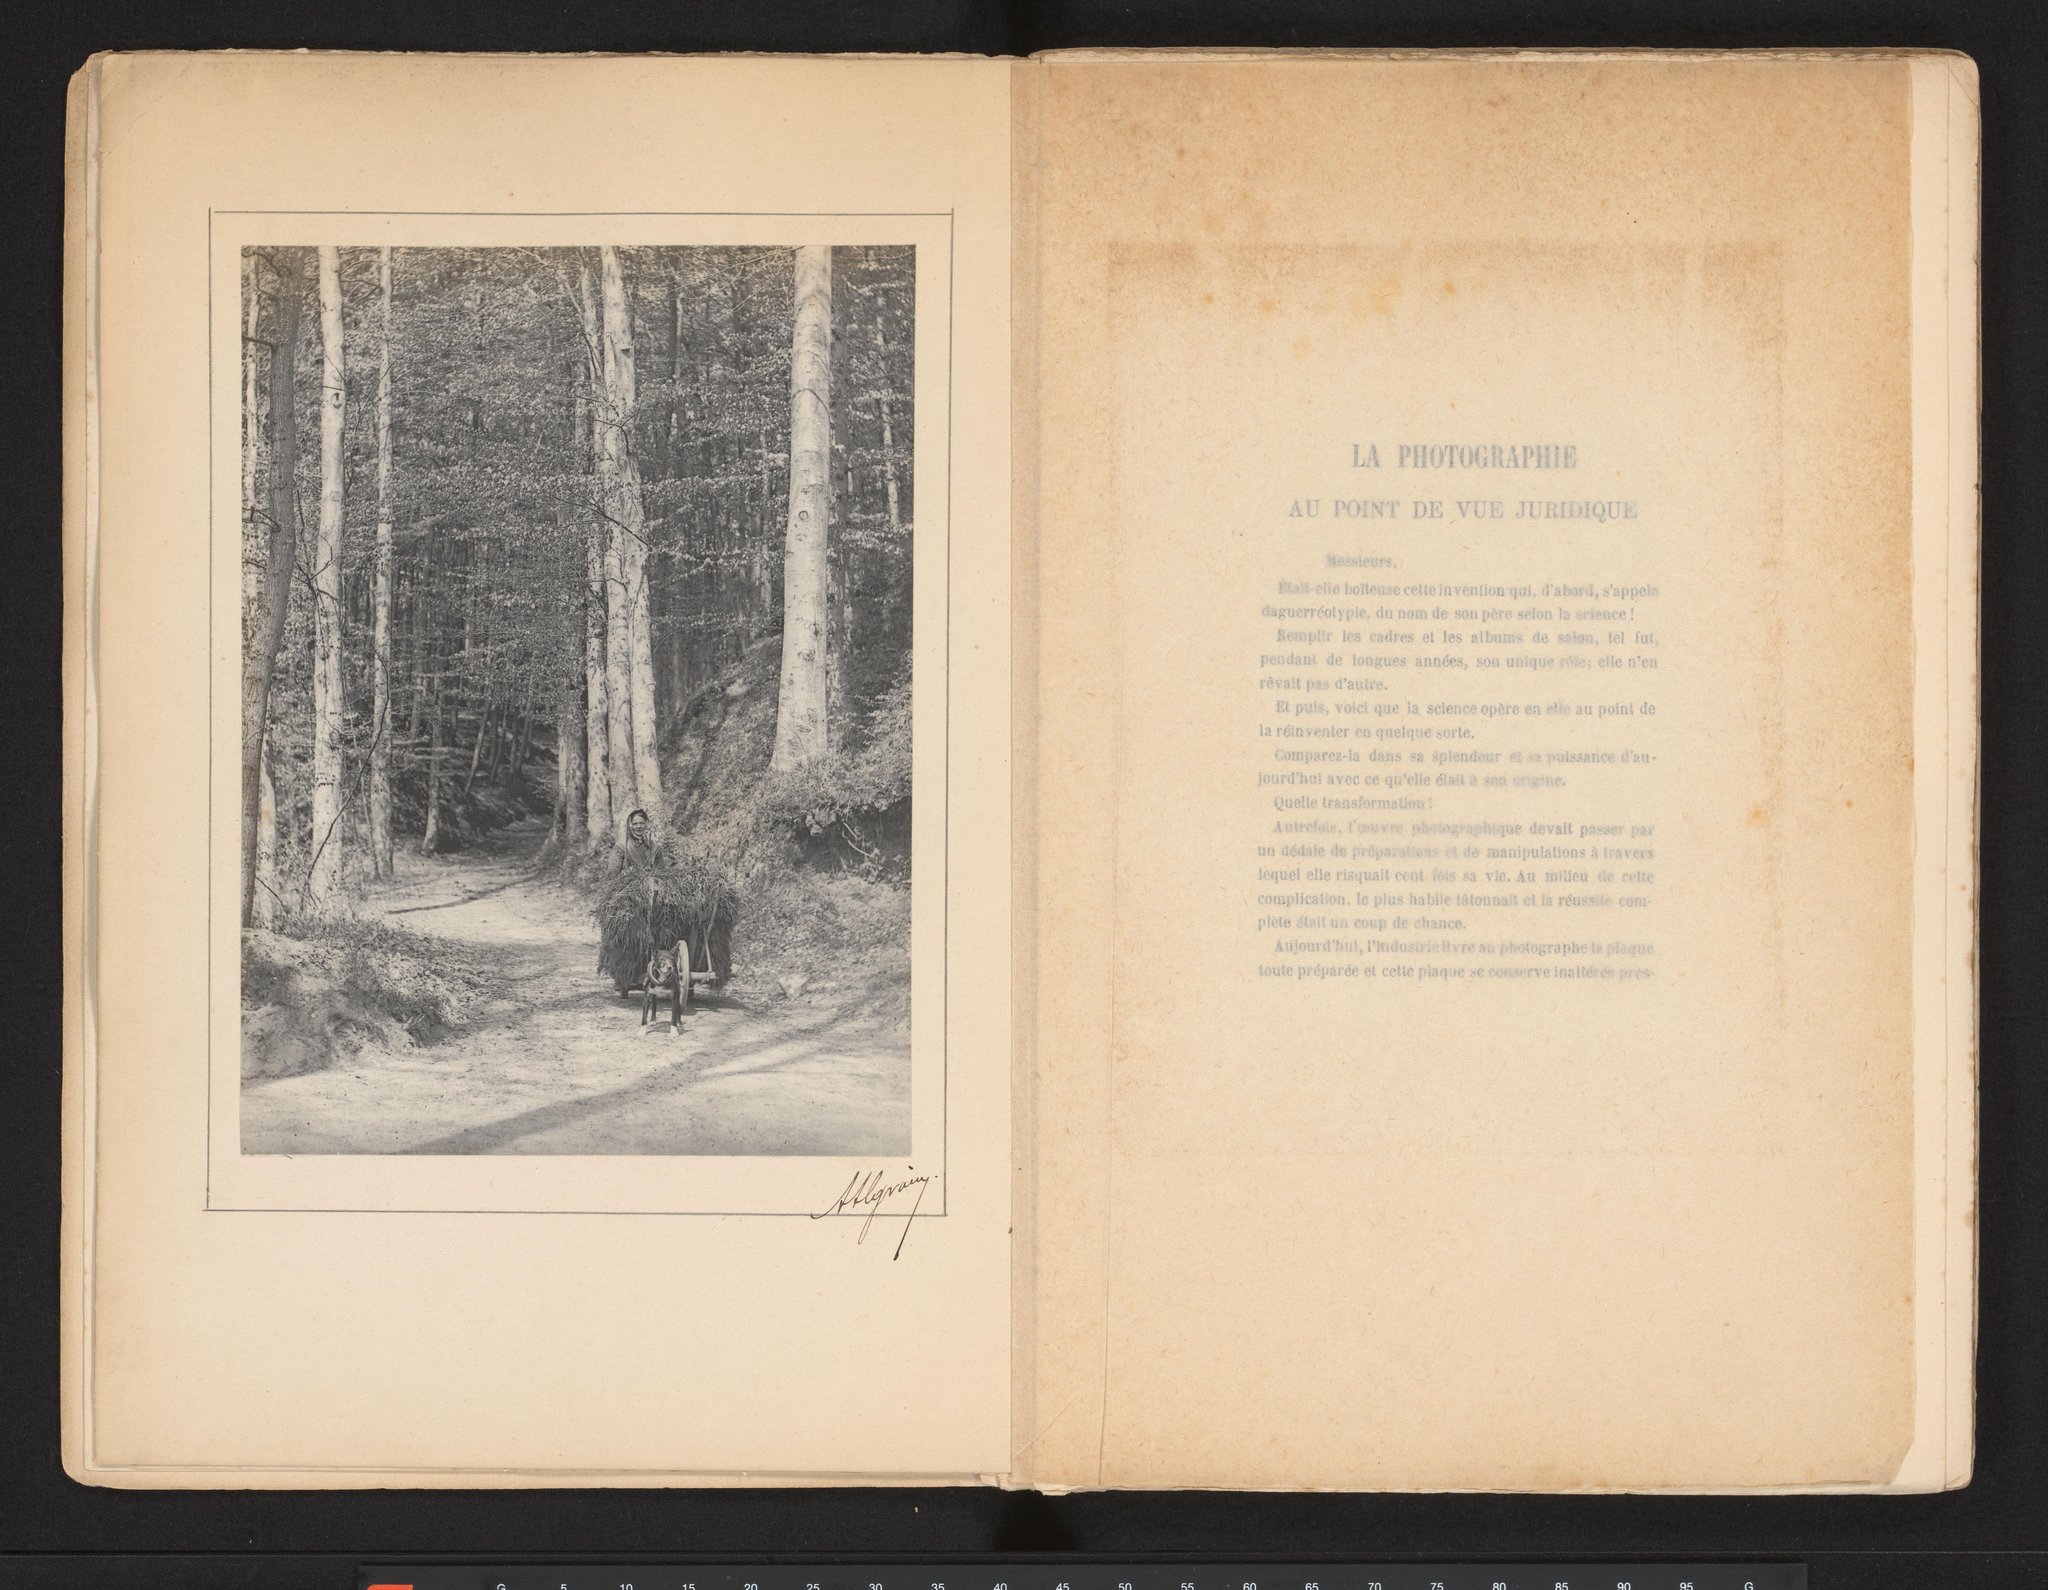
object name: page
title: Gezicht op een onbekende vrouw met een kar en een hond op een bospad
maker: alfred algrain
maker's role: fotograaf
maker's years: -1917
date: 1885-1890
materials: paper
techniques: platinum process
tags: hand-cart, historical persons, forest path or lane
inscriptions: signature: ‘Algrain’